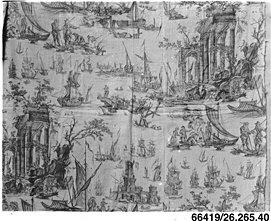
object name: furnishing textile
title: Pictorial print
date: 1780-1785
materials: linen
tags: ships